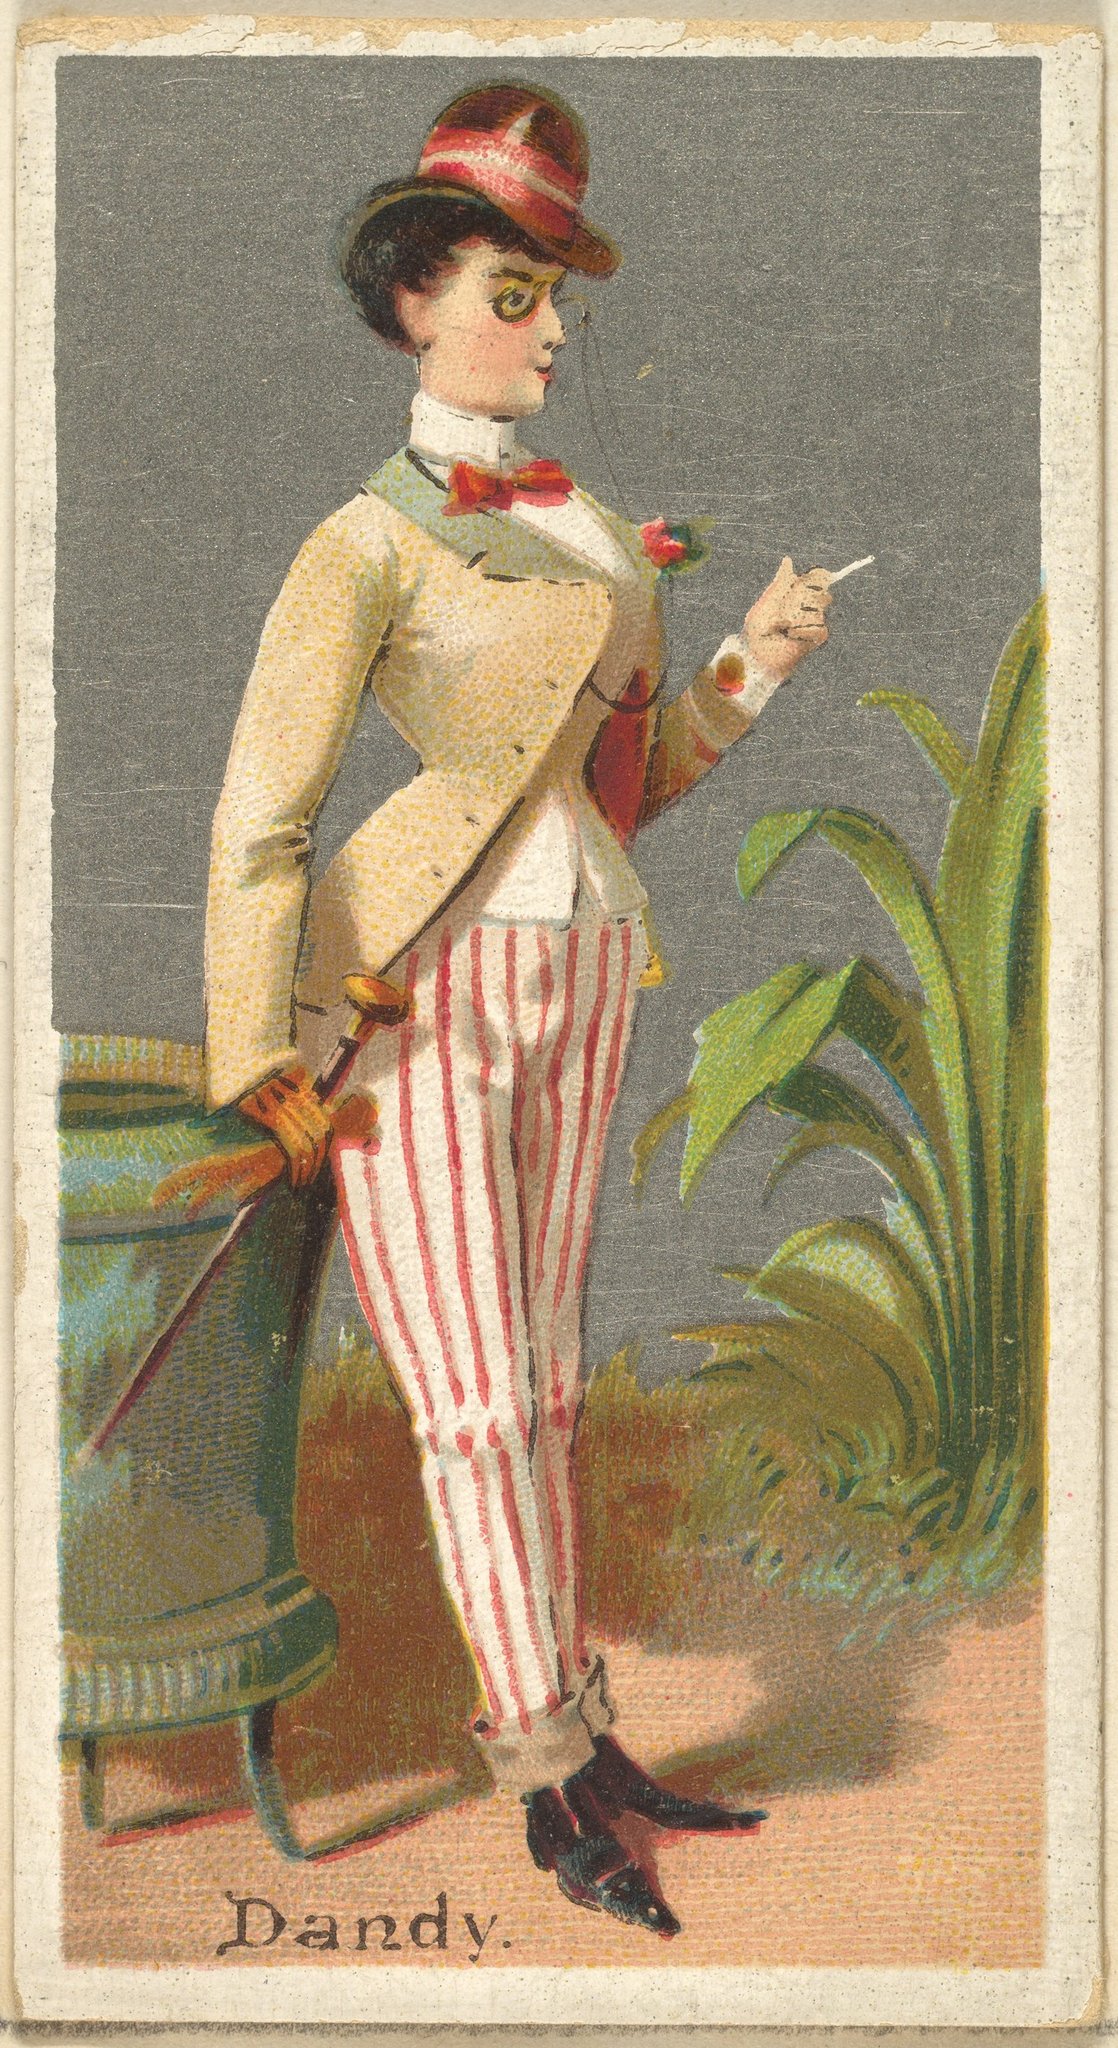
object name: print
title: Dandy, from the Occupations for Women series (N166) for Old Judge and Dogs Head Cigarettes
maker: goodwin & company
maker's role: publisher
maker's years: 1850-1950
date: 1887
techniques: color lithograph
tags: women,smoking